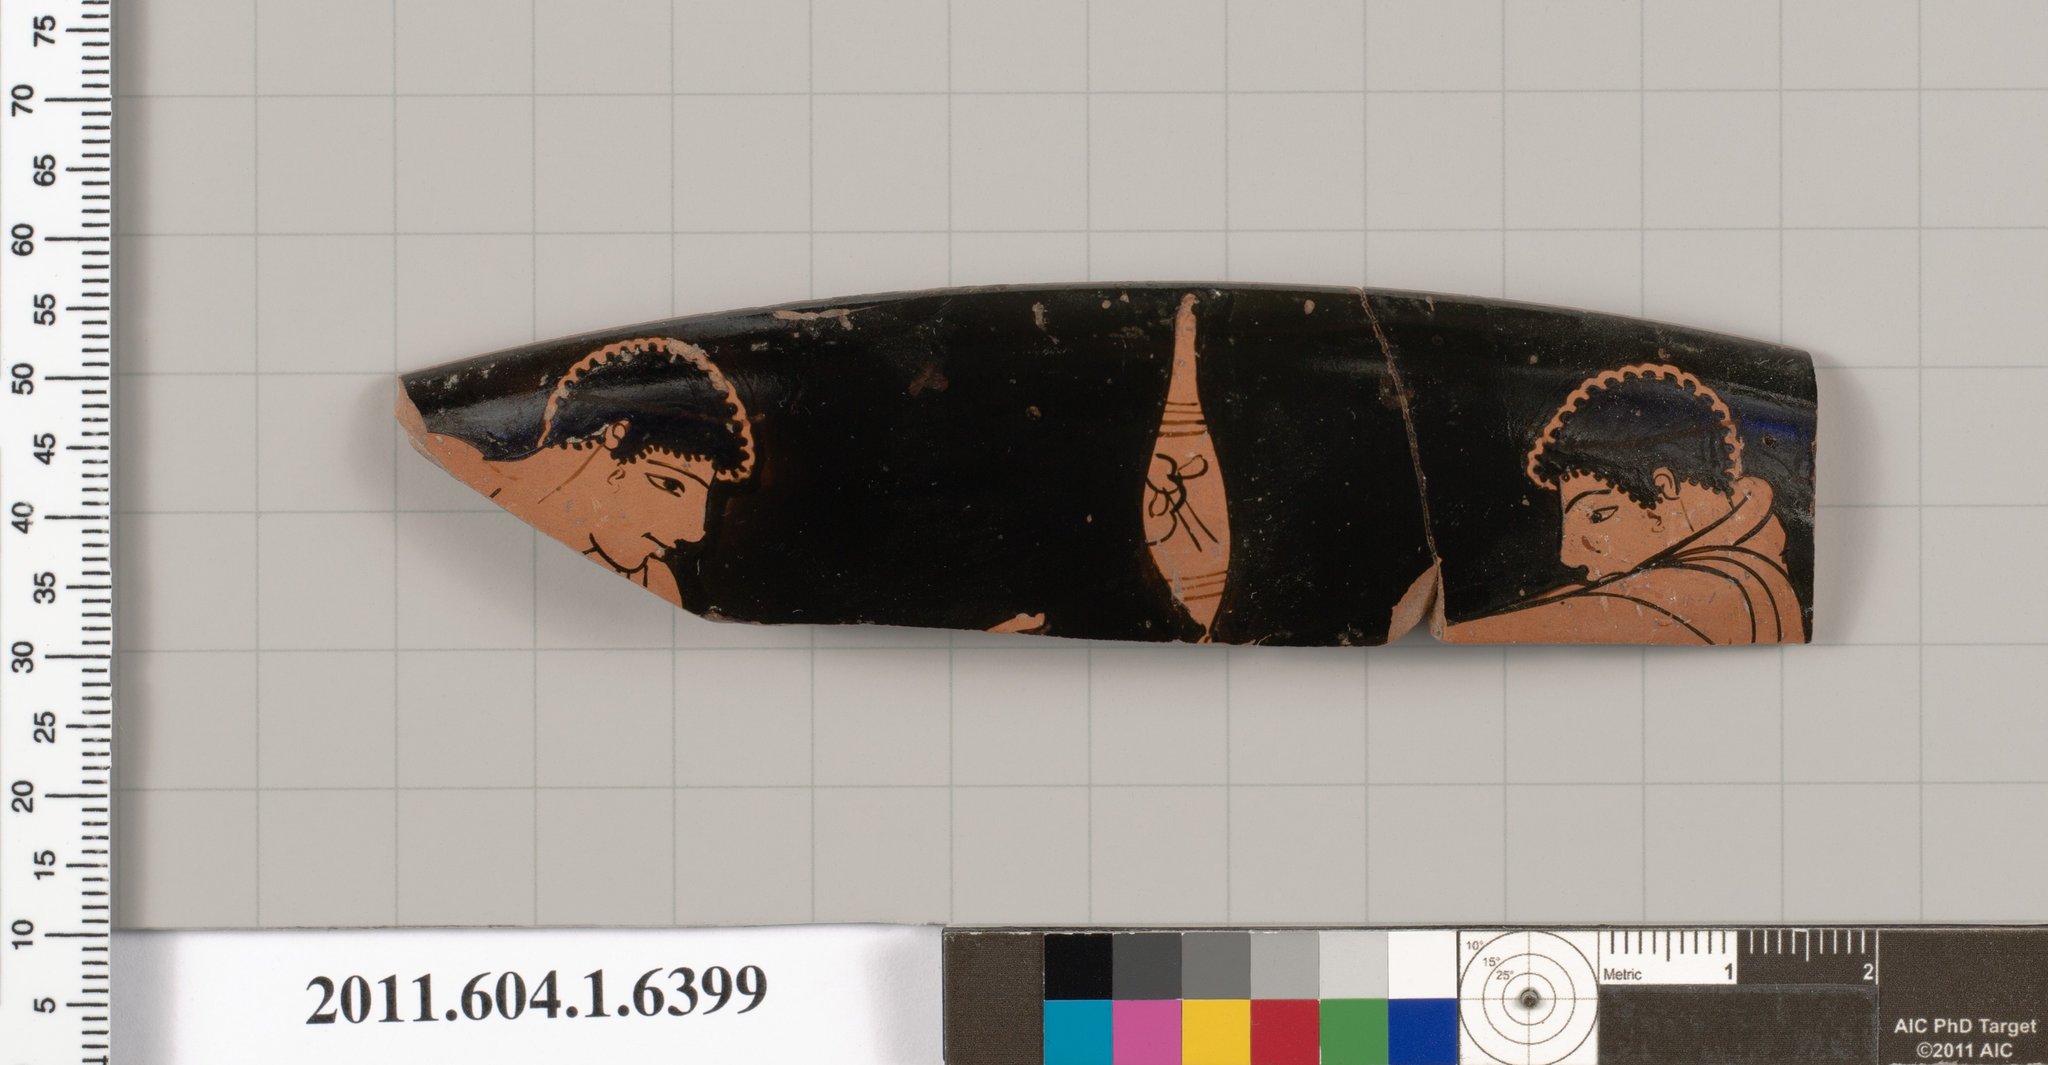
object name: kylix fragment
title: Terracotta rim fragment of a kylix (drinking cup)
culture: greek, attic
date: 490-480 BCE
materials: terracotta